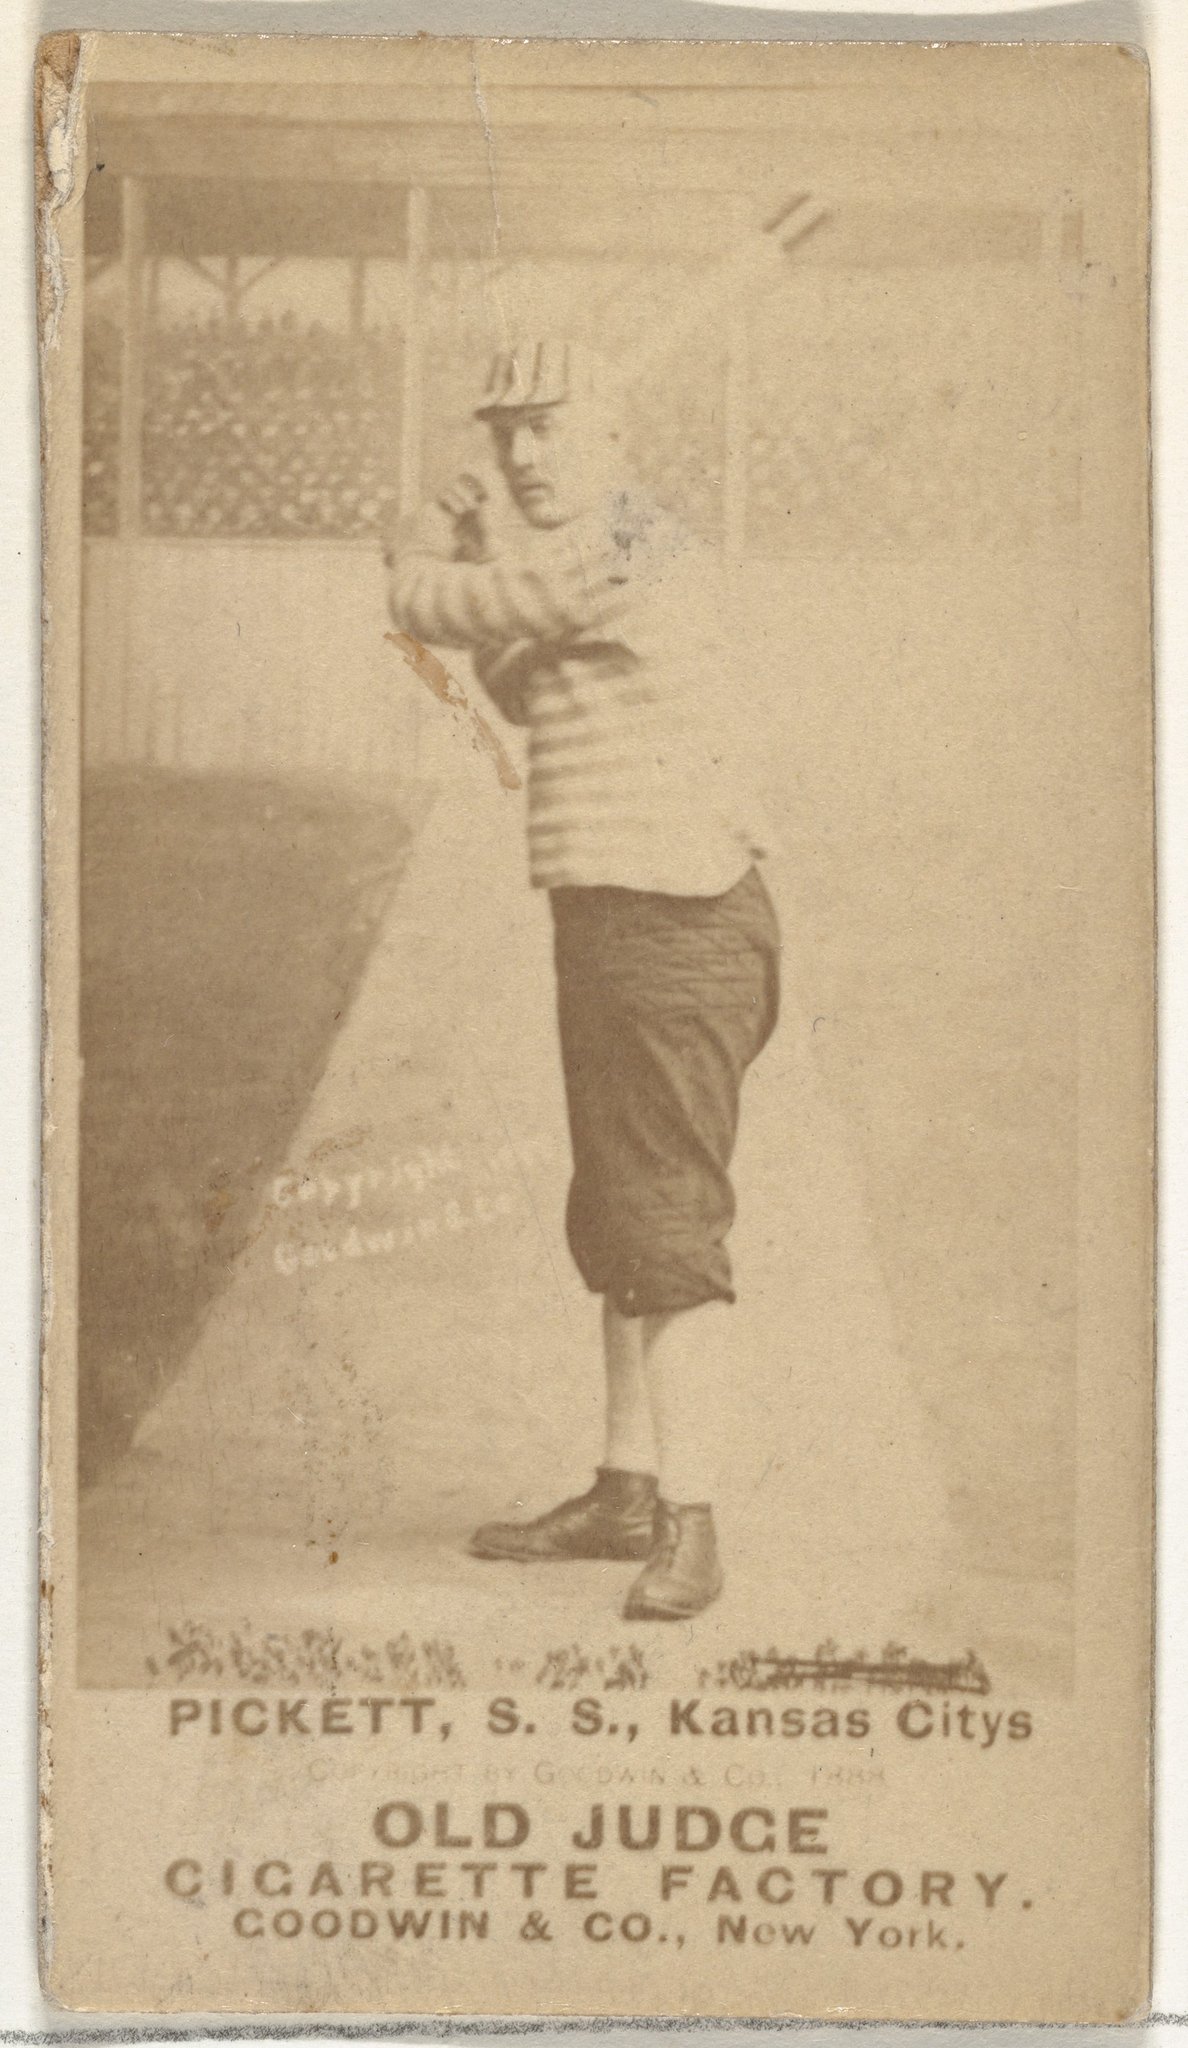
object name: baseball card, photograph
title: John Thomas Pickett, Shortstop, Kansas City Cowboys, from the Old Judge series (N172) for Old Judge Cigarettes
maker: goodwin & company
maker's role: publisher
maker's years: 1850-1950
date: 1888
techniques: albumen silver print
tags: men,portraits,baseball,athletes